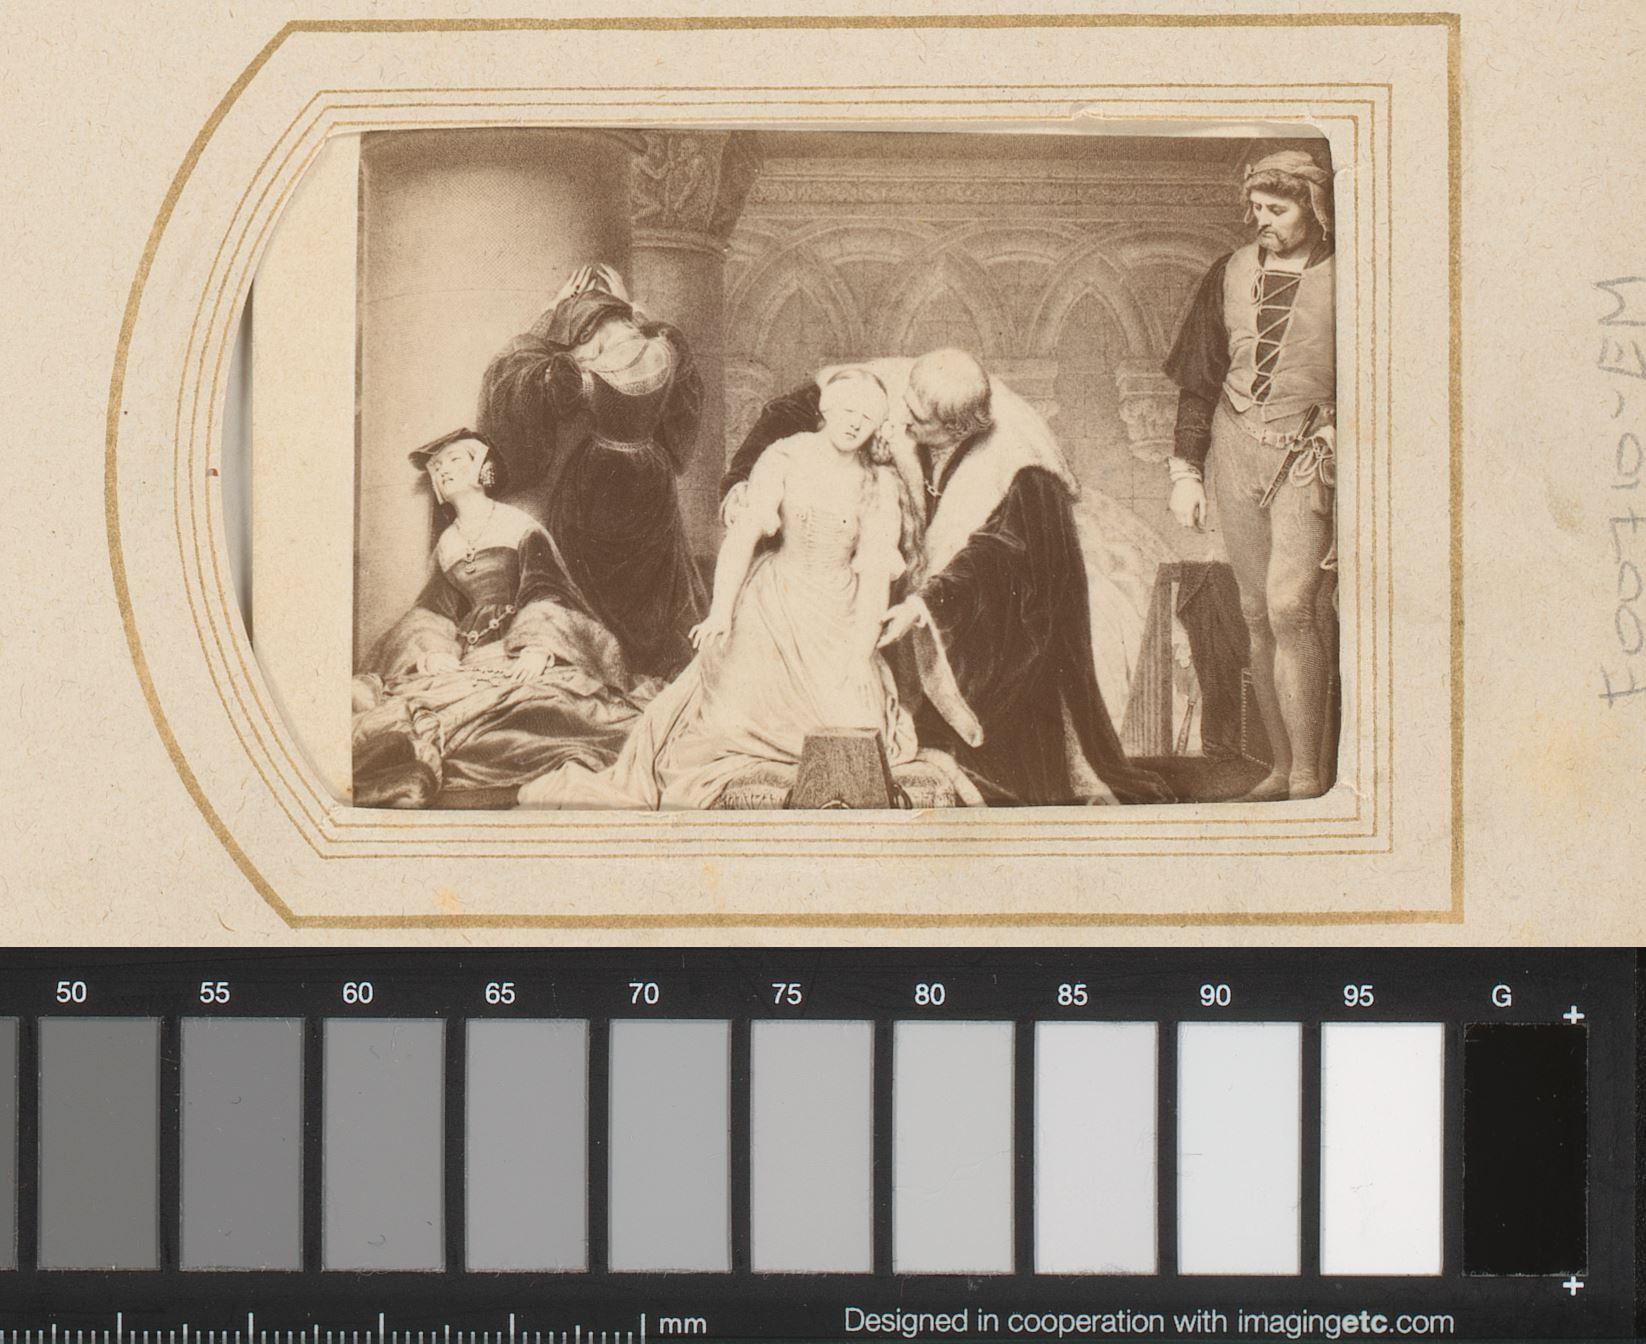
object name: carte de visite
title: Fotoreproductie van een schilderij van de onthoofding van Lady Jane Grey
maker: Anonymous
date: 1870-1900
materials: cardboard, photographic support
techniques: albumen print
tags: london, adult woman, adult man, violent death by beheading, painting, drawing and the graphic arts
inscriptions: annotation: ‘[...] Jane Grey’